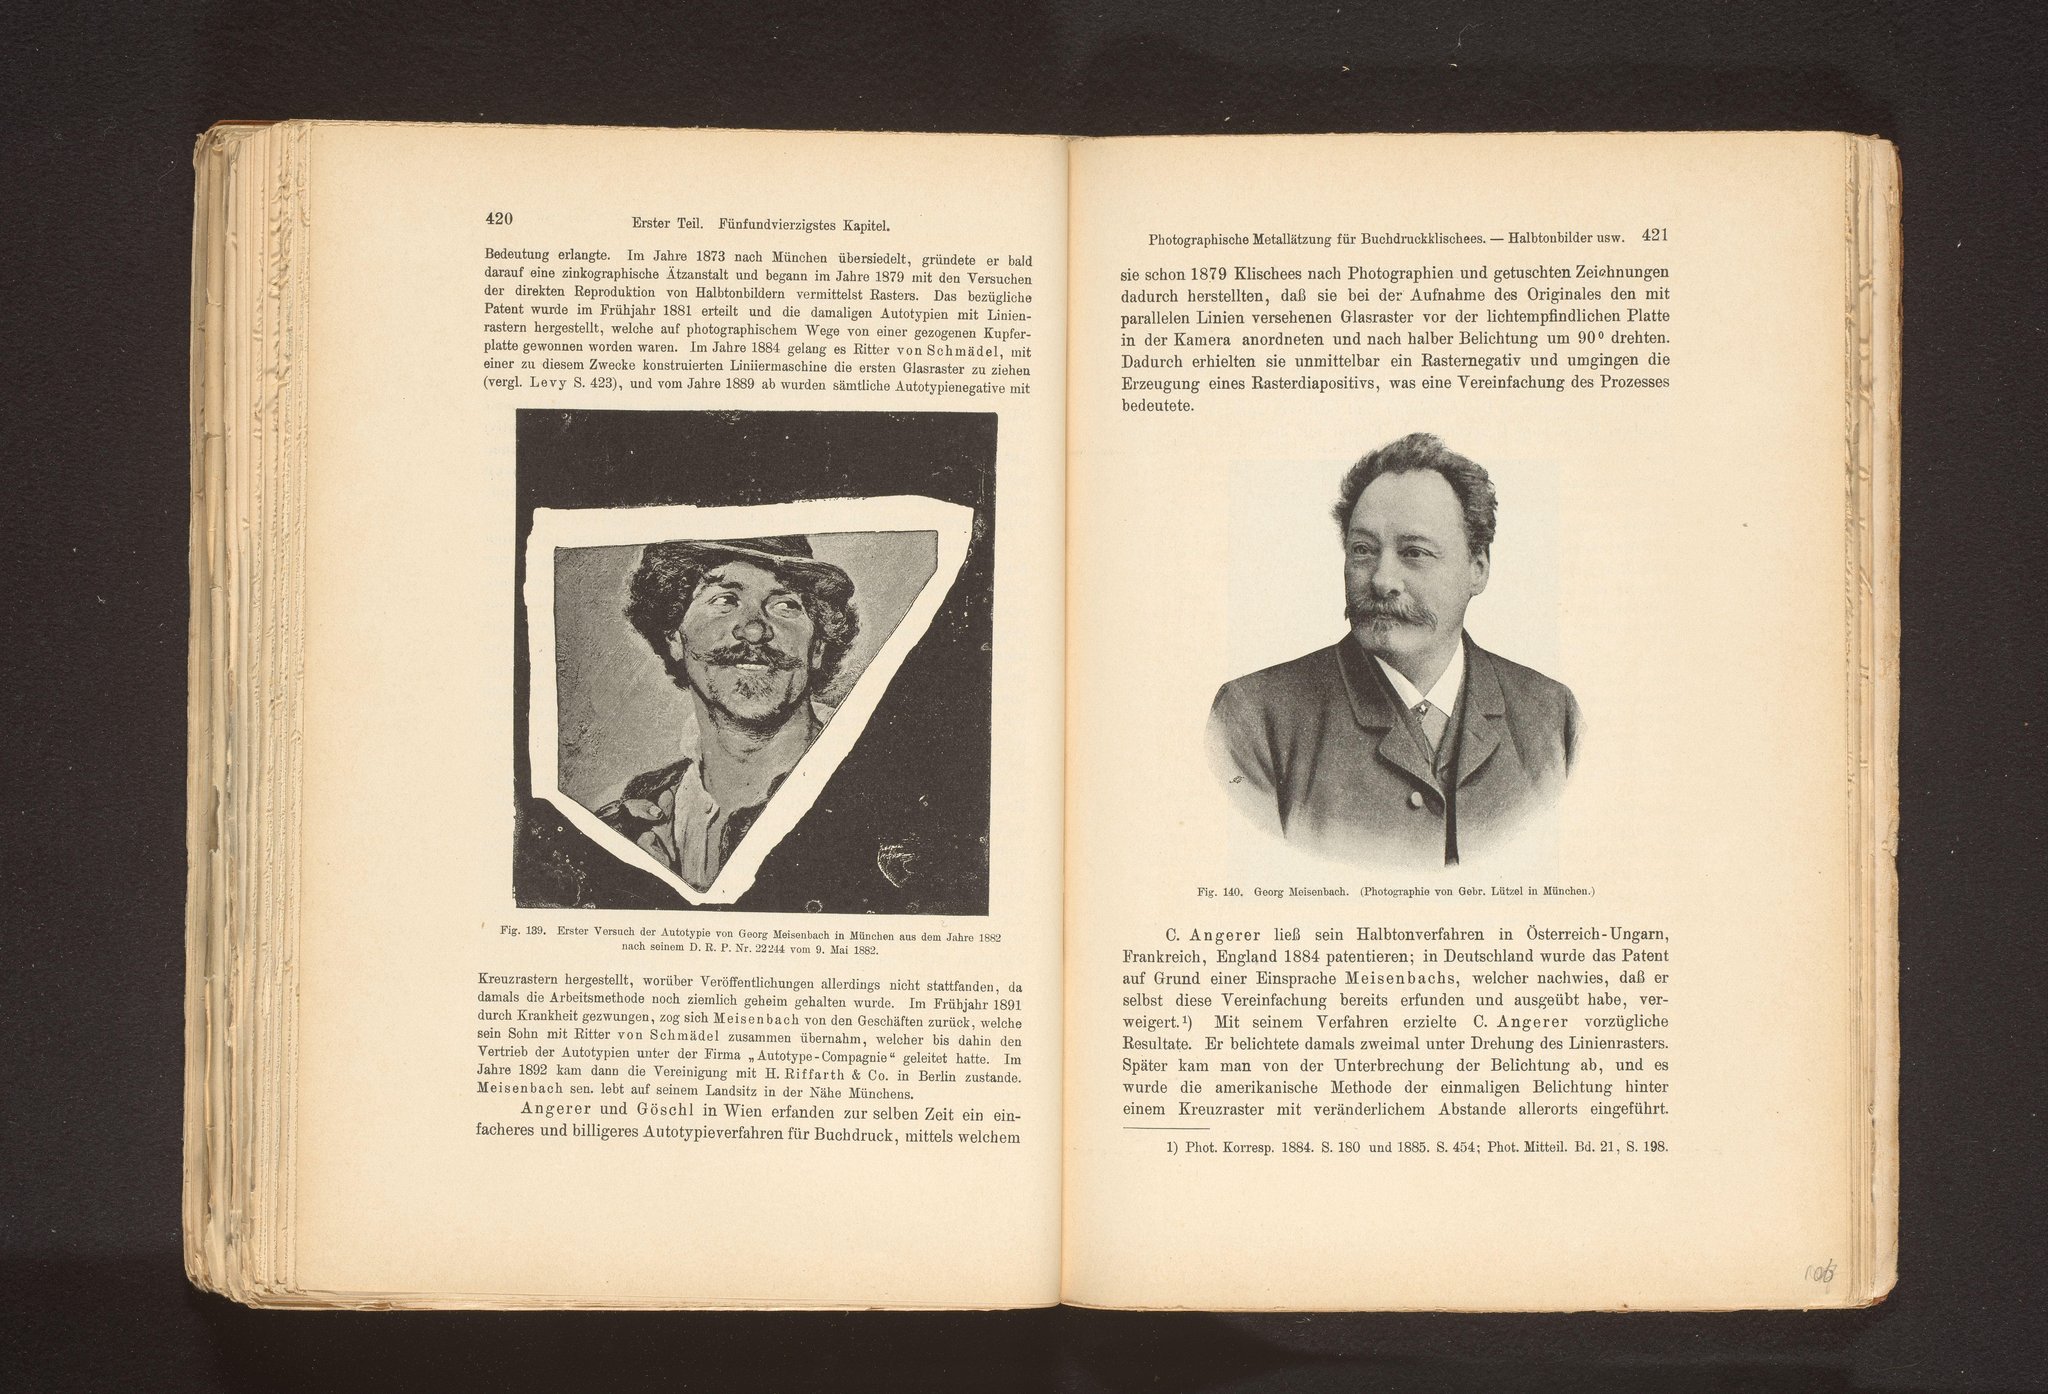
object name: page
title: Portret van Georg Meisenbach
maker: Anonymous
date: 1900-1905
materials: paper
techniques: autotype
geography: munich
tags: georg meisenbach, adult man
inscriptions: number: ‘Fig. 140.’